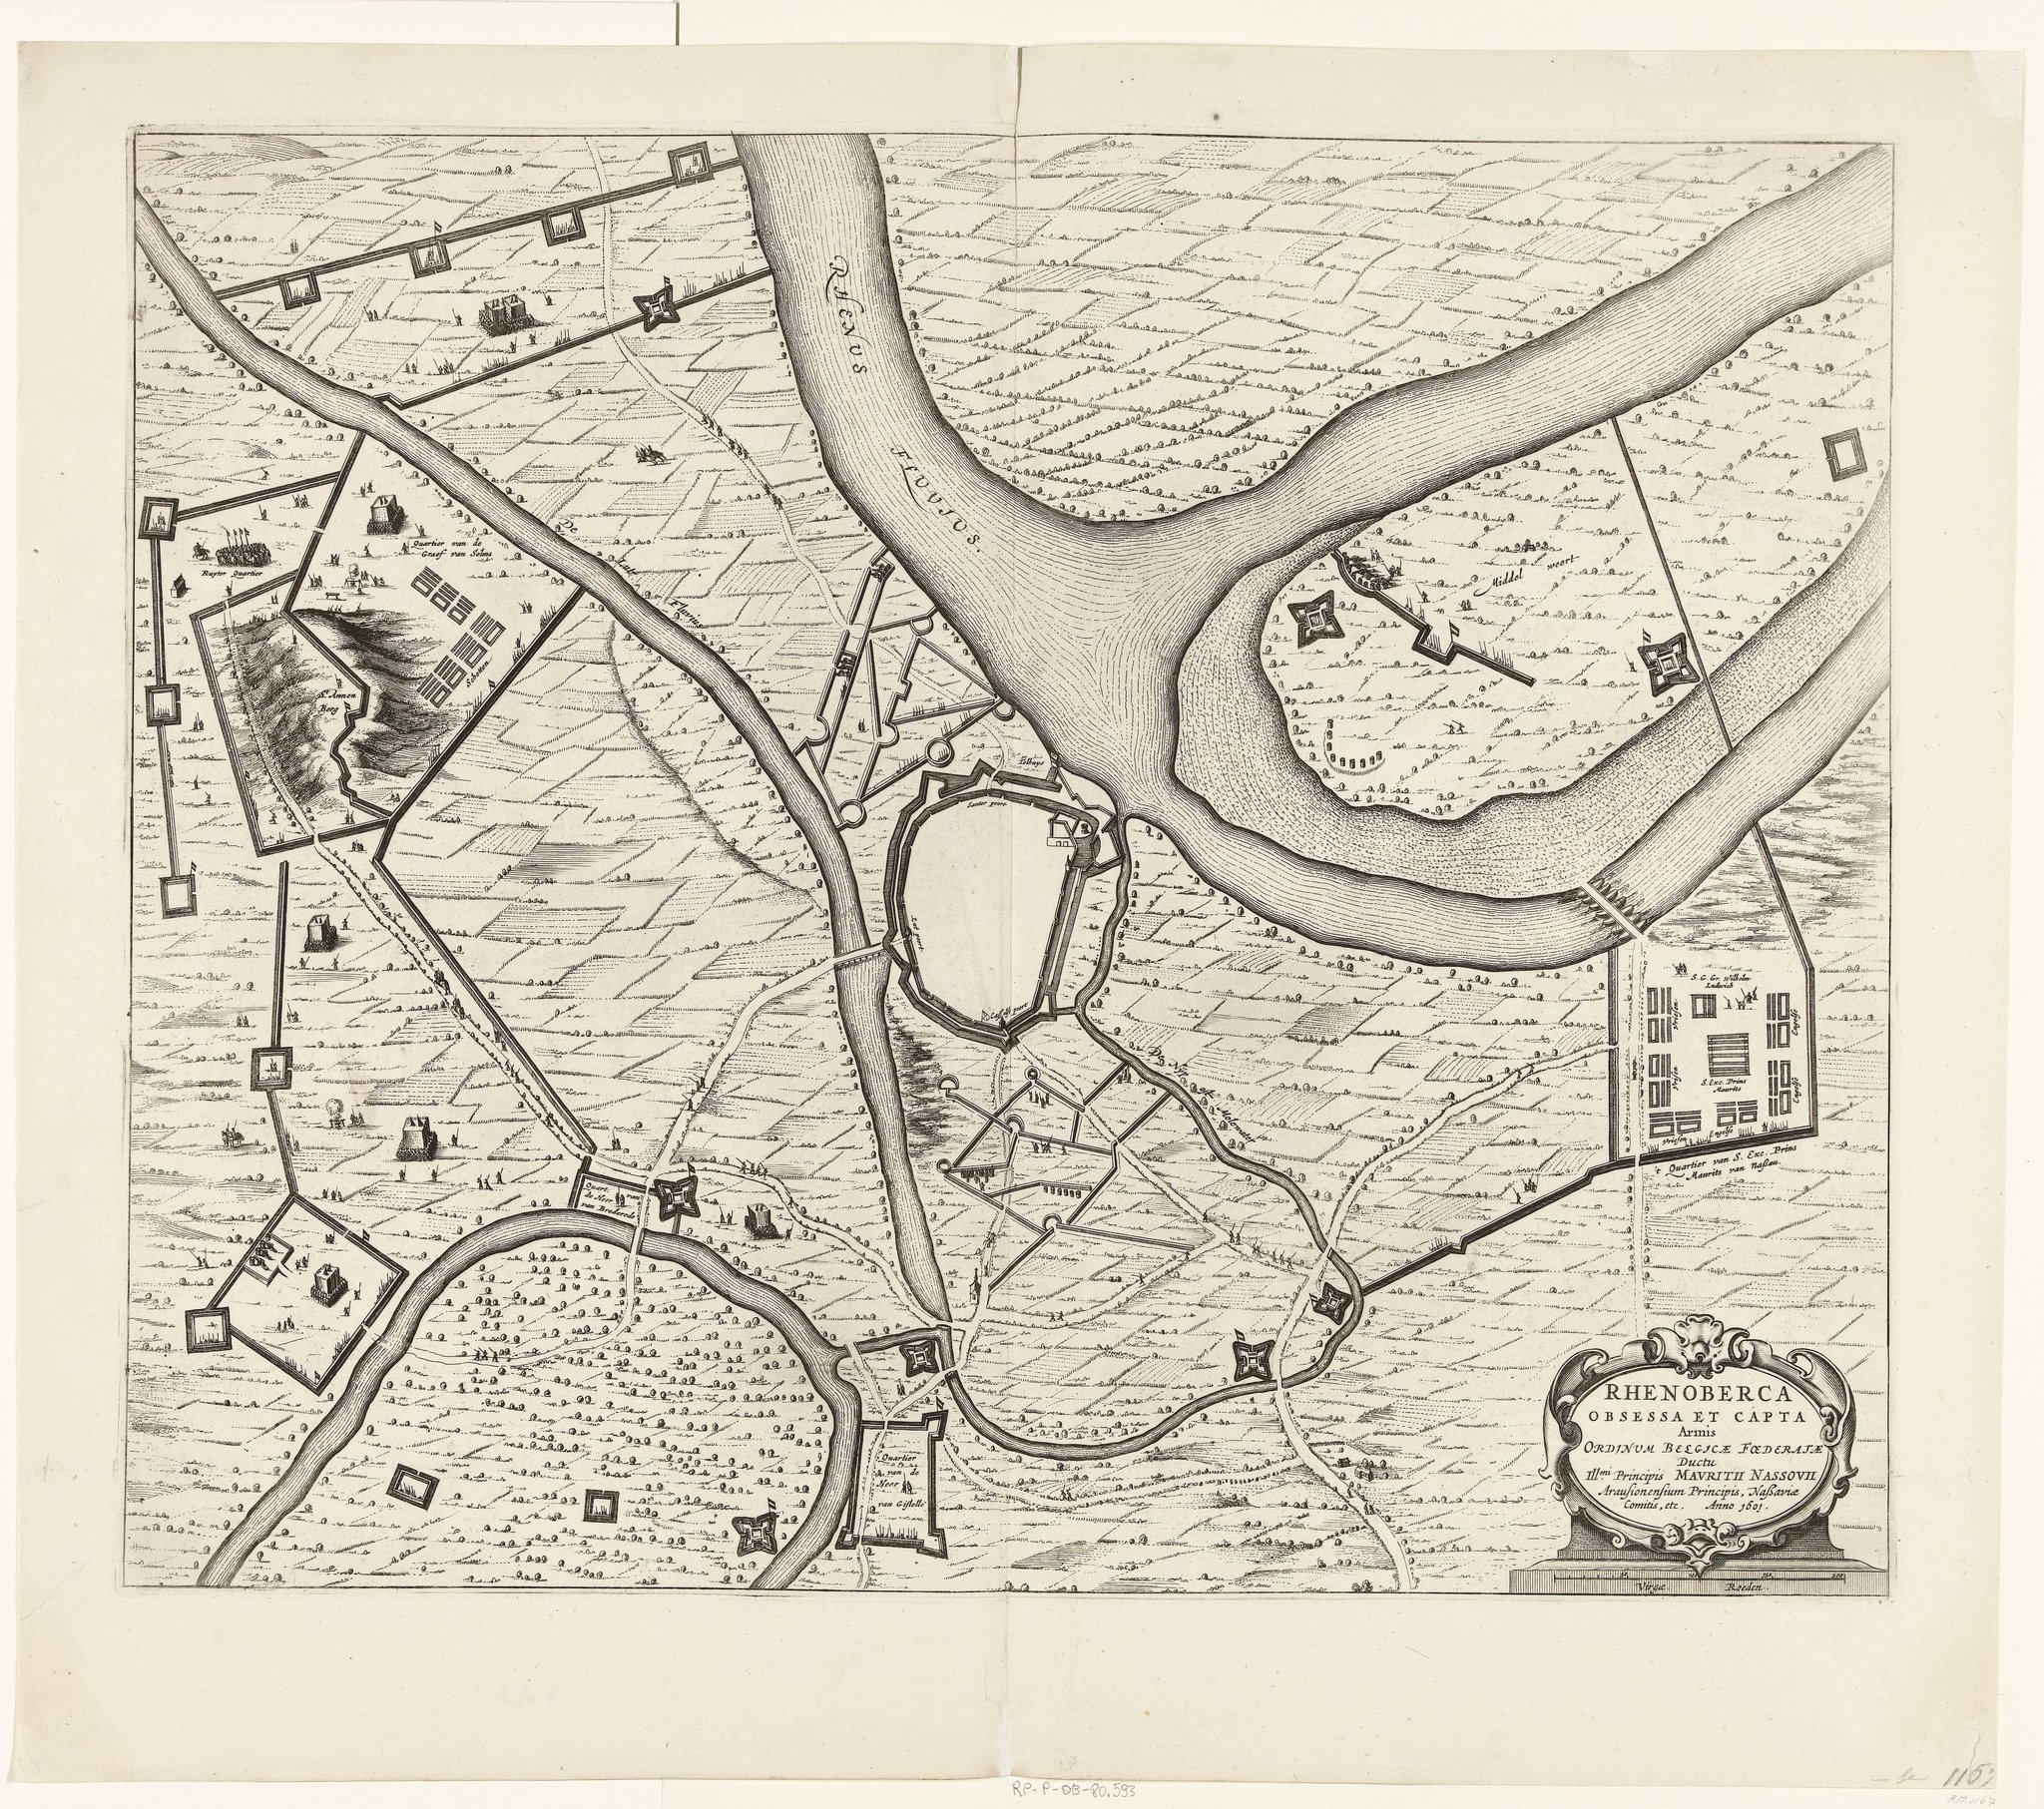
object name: map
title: Beleg en inname van Rheinberg door Maurits, 1601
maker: Anonymous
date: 1647-1649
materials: paper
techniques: engraving, etching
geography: northern netherlands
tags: maurice (prince of orange), maps of separate countries or regions, siege, position war, capture of city (after the siege)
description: Kaart van de stad Rheinberg en het omliggende land tijdens de belegering vanaf 12 juni en verovering op 31 juli 1601 door het Staatse leger onder prins Maurits. Plan van de verdedigingswerken van de stad en in het omliggende land, met de legerkampen van de belegeraars. Bovenaan de Rijn. Rechtsonder een cartouche met de titel in het Latijn. Dubbelblad genomen uit het Stedenboek van Blaeu.